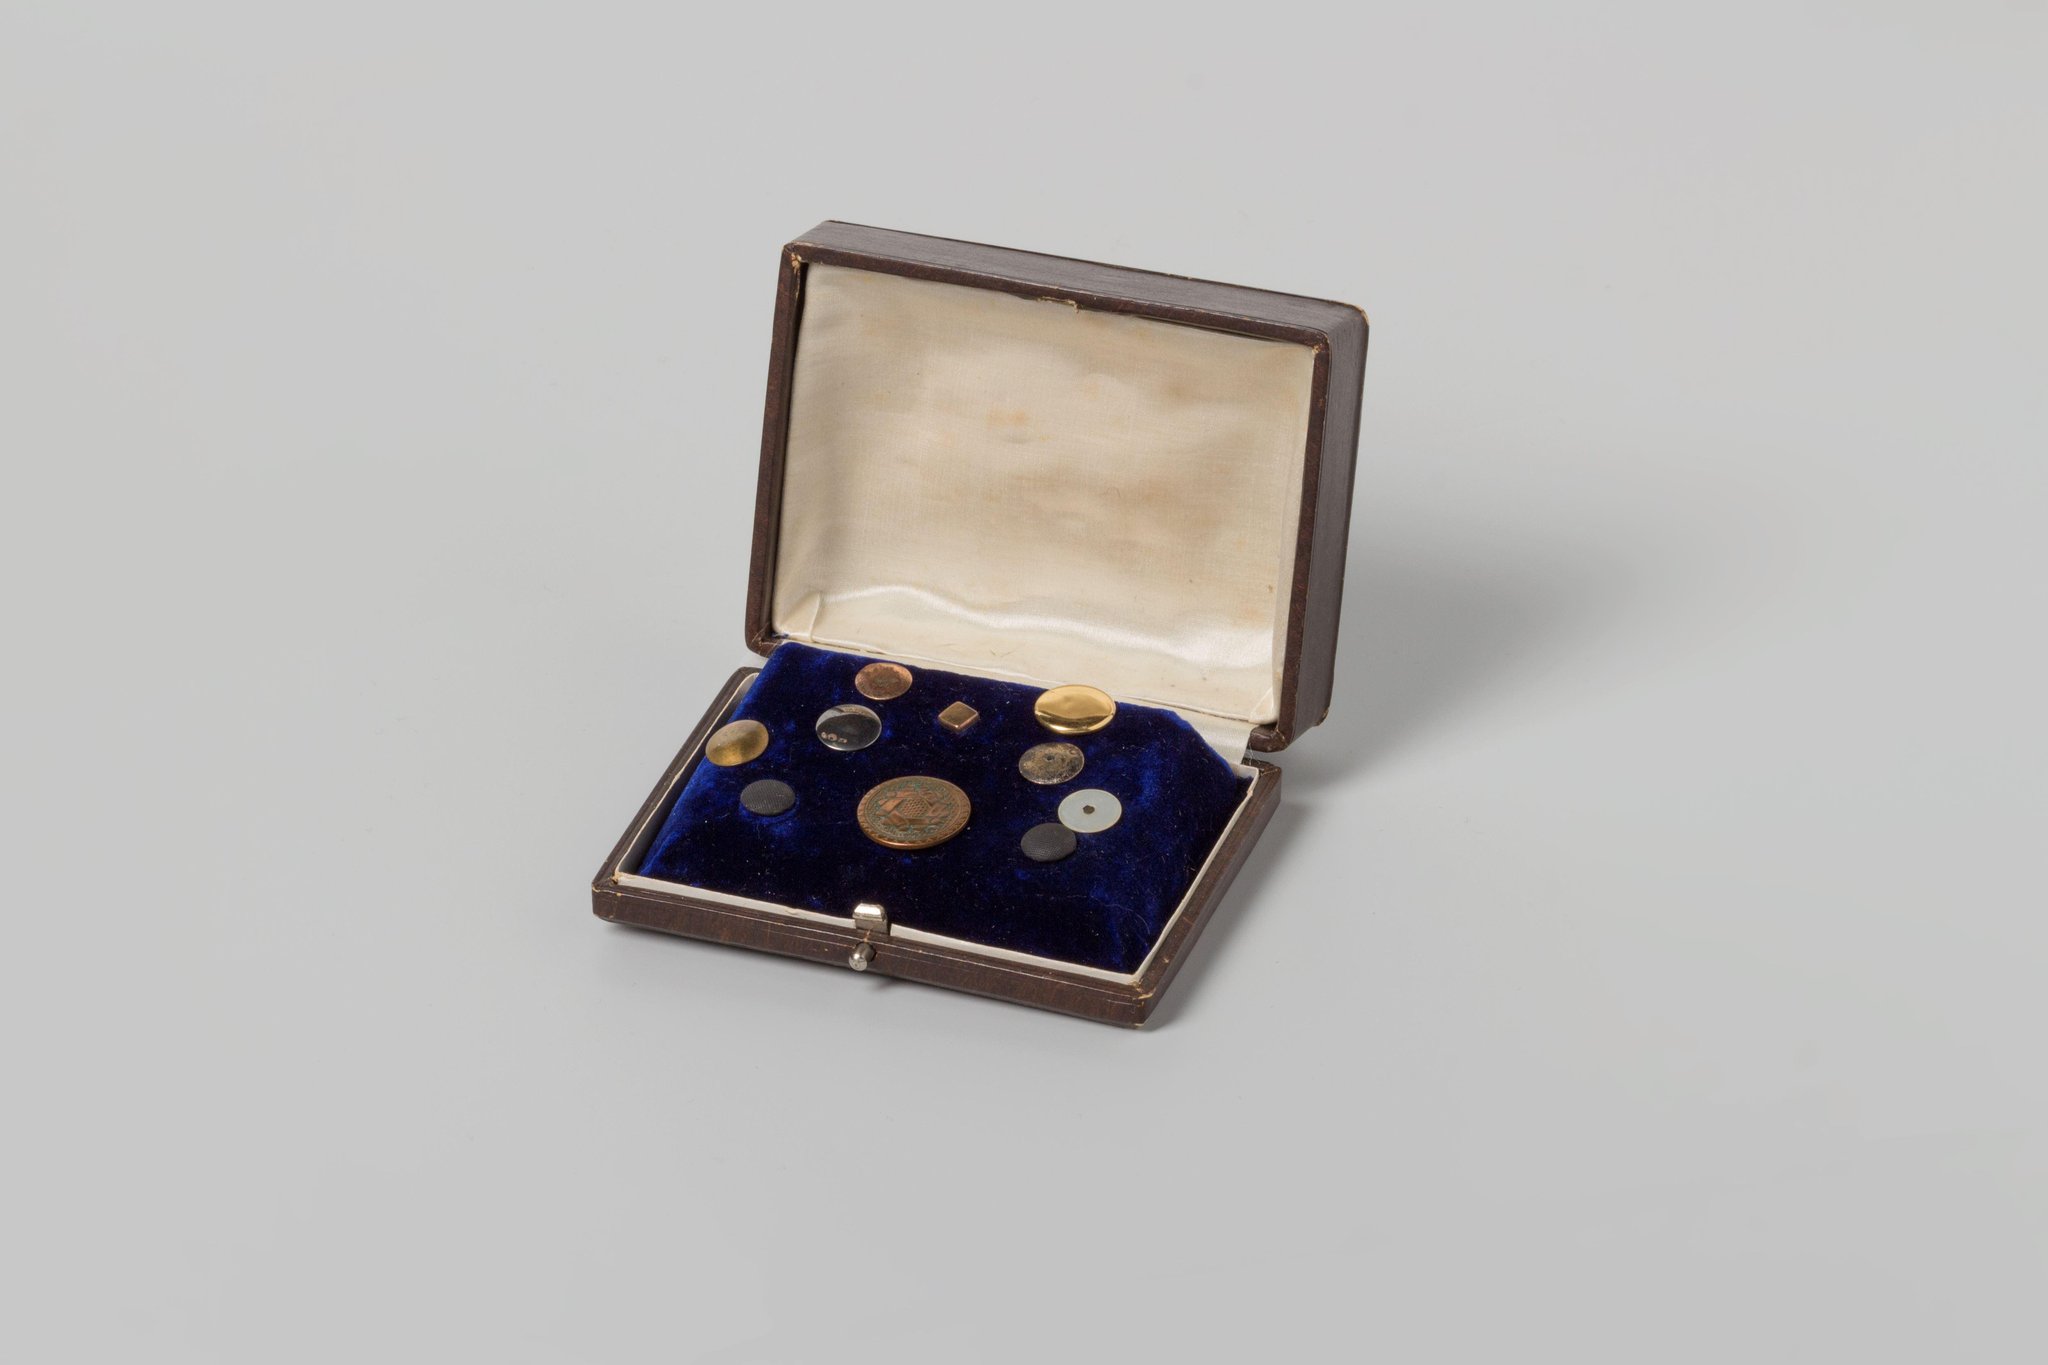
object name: menswear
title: Vierkante vestknoop of boordeknoop van koper en zwart kunststof; voor de rouw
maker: Anonymous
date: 1900-1925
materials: copper, plastic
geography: western europe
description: Vierkante vestknoop of boordeknoop van koper en zwart kunststof. Voor de rouw.